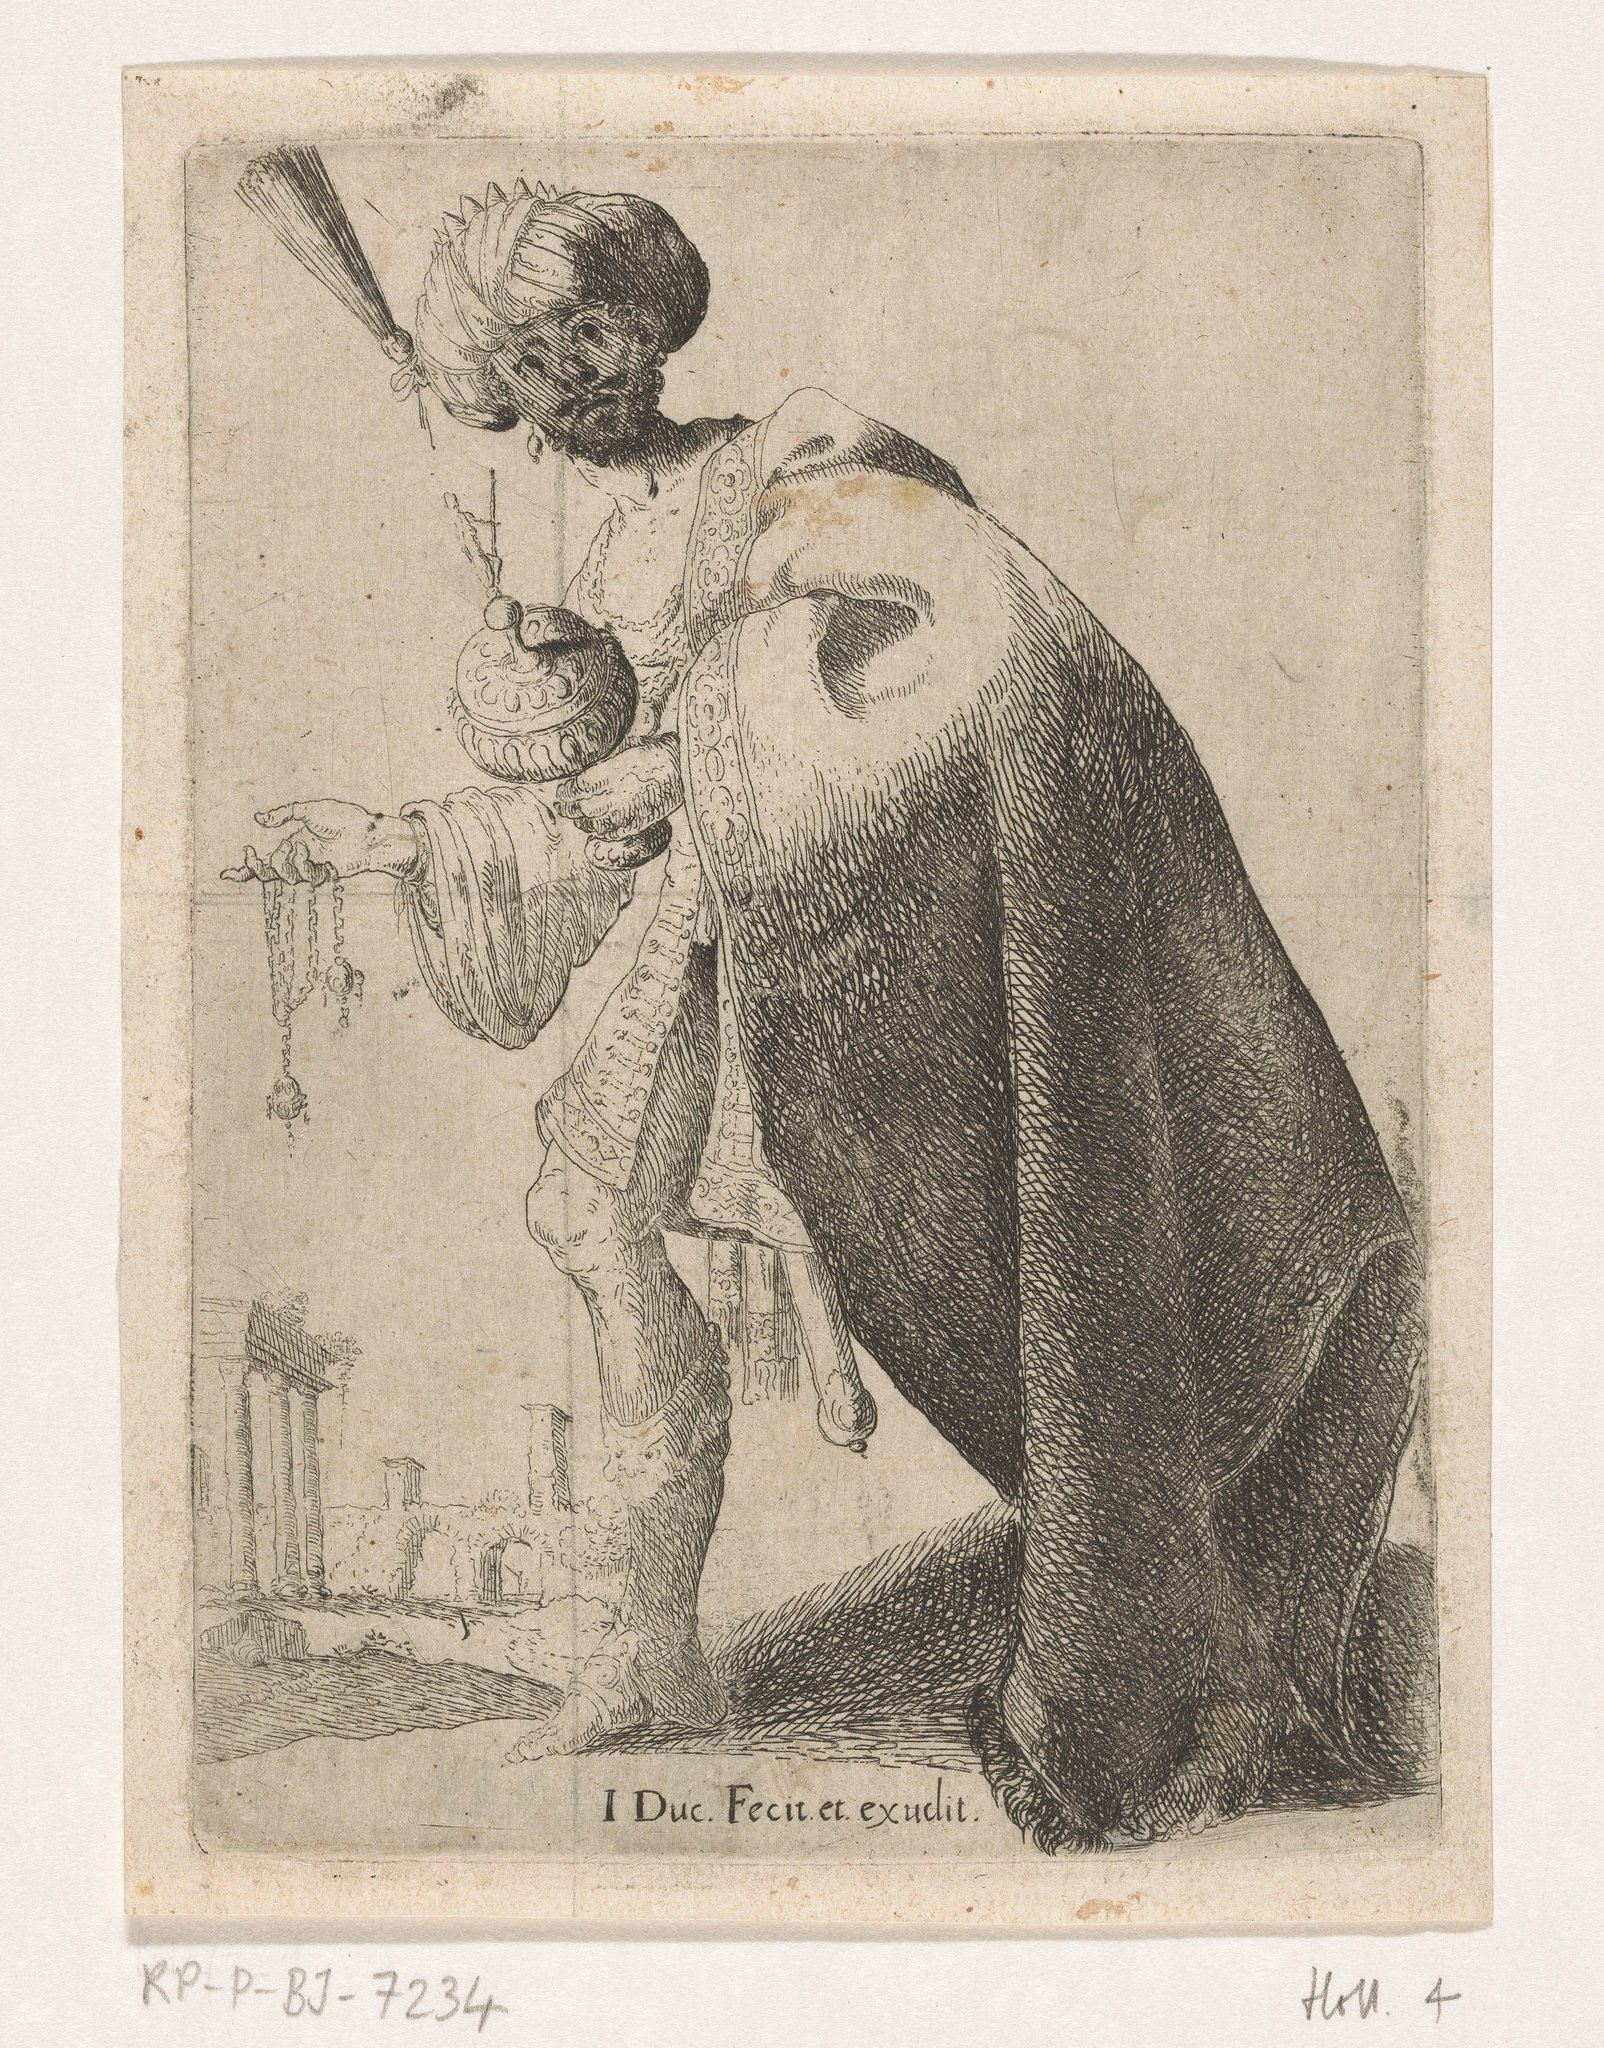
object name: print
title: Koning met wierookvat en sieraden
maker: jacob duck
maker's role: draughtsman, painter, print maker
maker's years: 1600-1667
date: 1621-1667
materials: paper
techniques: etching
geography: utrecht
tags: adoration of the kings: the wise men present their gifts to the christ-child (gold, frankincense and myrrh)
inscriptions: collector's mark: Lugt 778, collector's mark: Lugt 2228